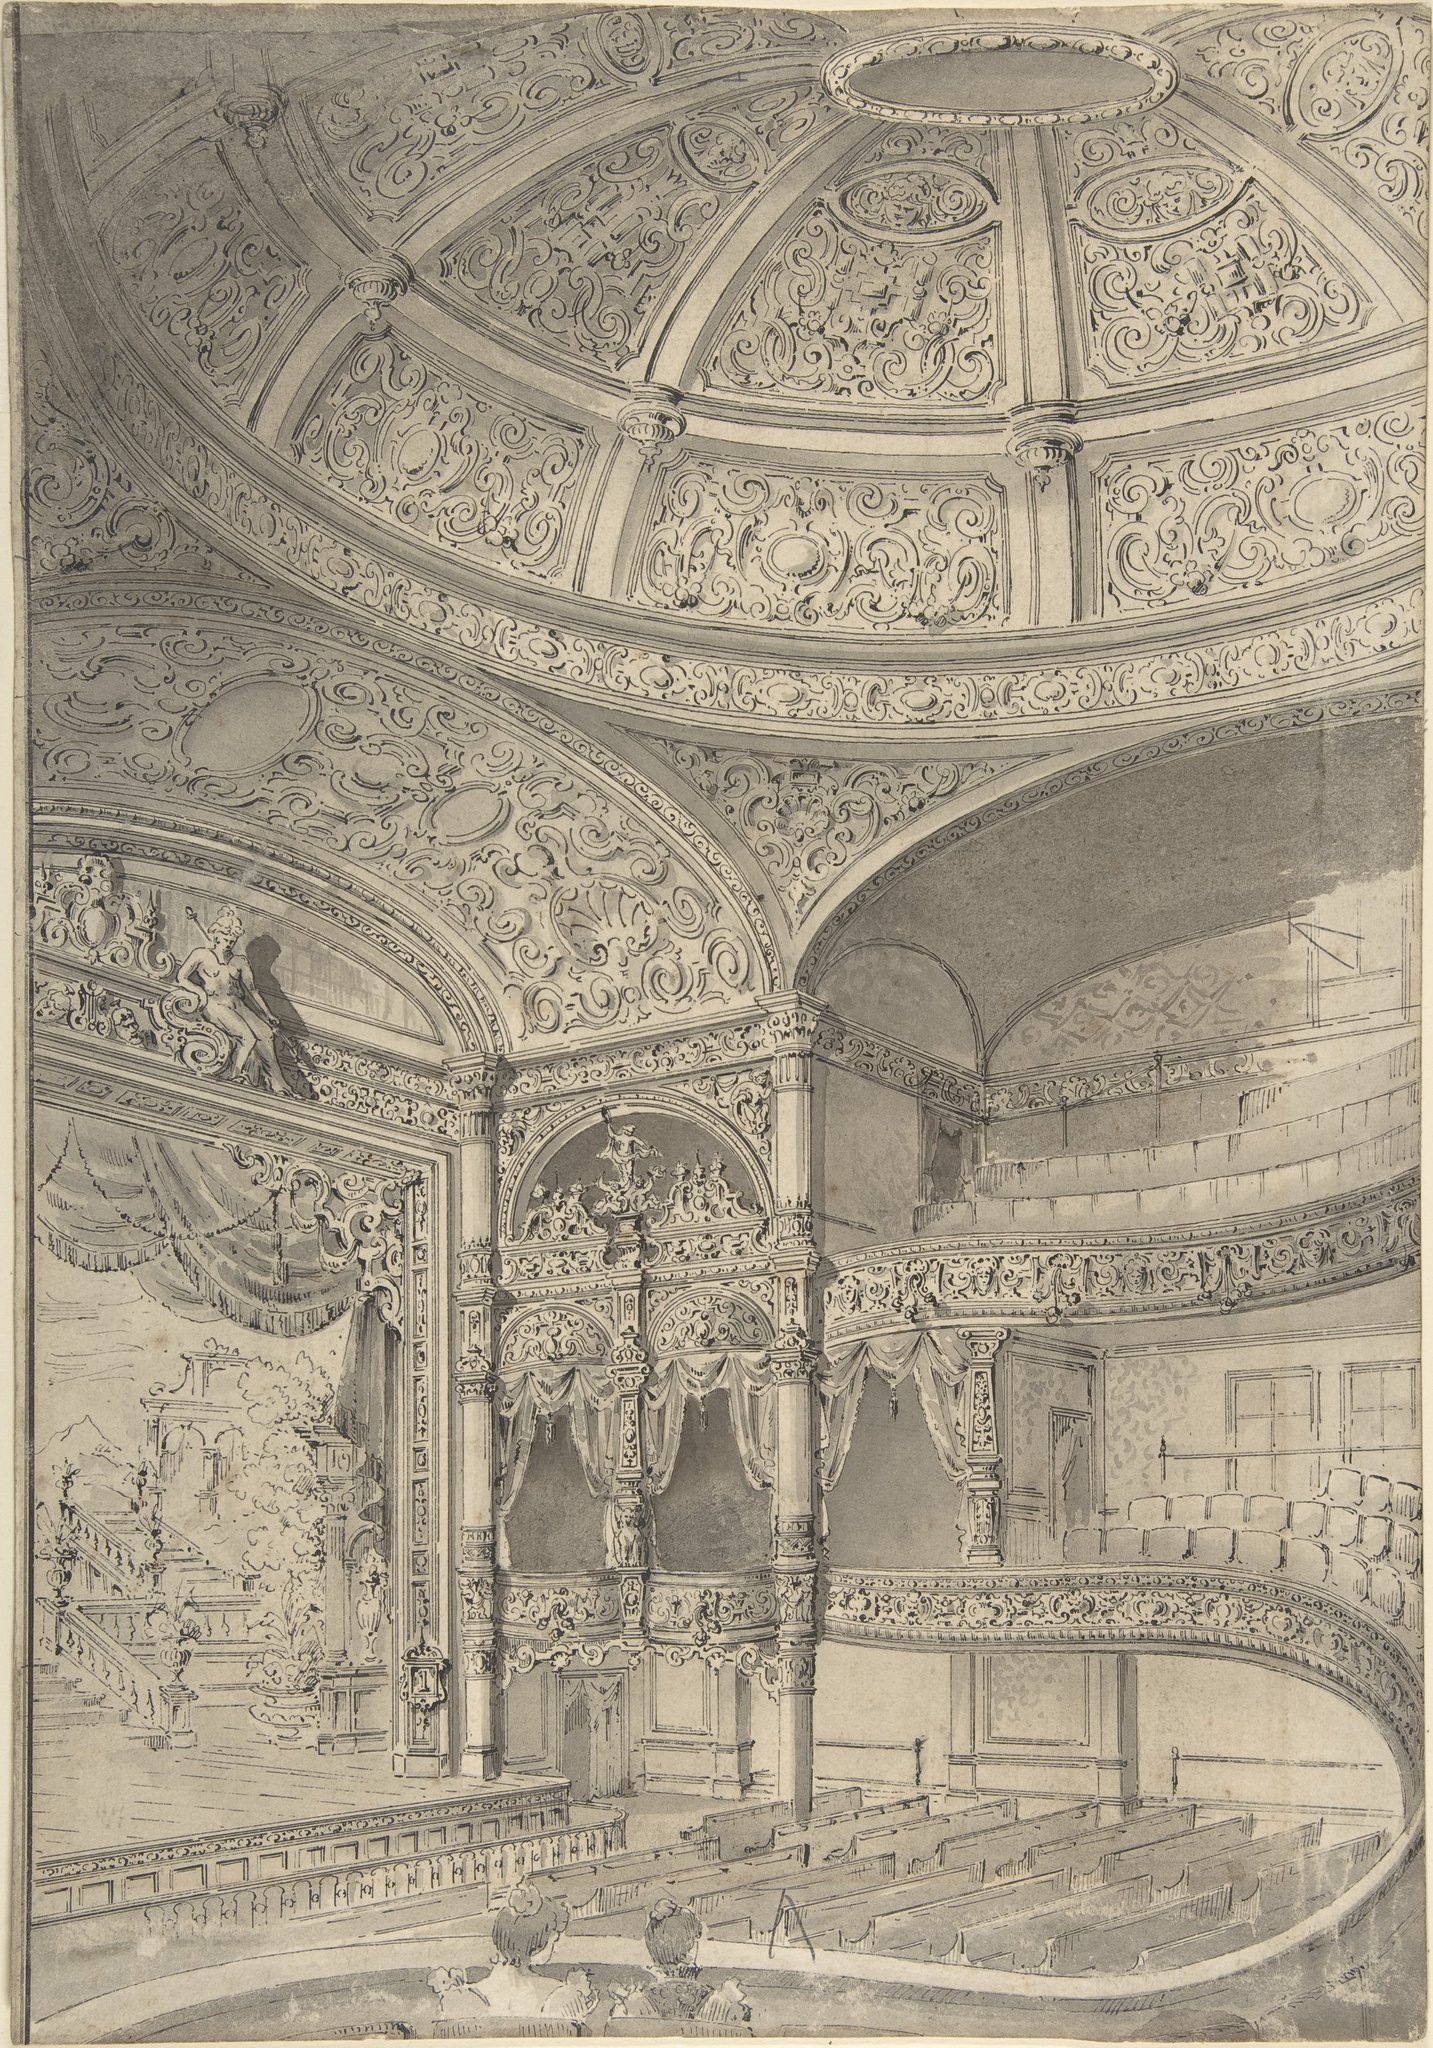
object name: drawing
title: Interior of a Theatre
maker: david roberts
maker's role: artist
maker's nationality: british, scottish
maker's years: 1796-1864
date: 1796-1864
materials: ink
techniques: pen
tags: theatre,interiors